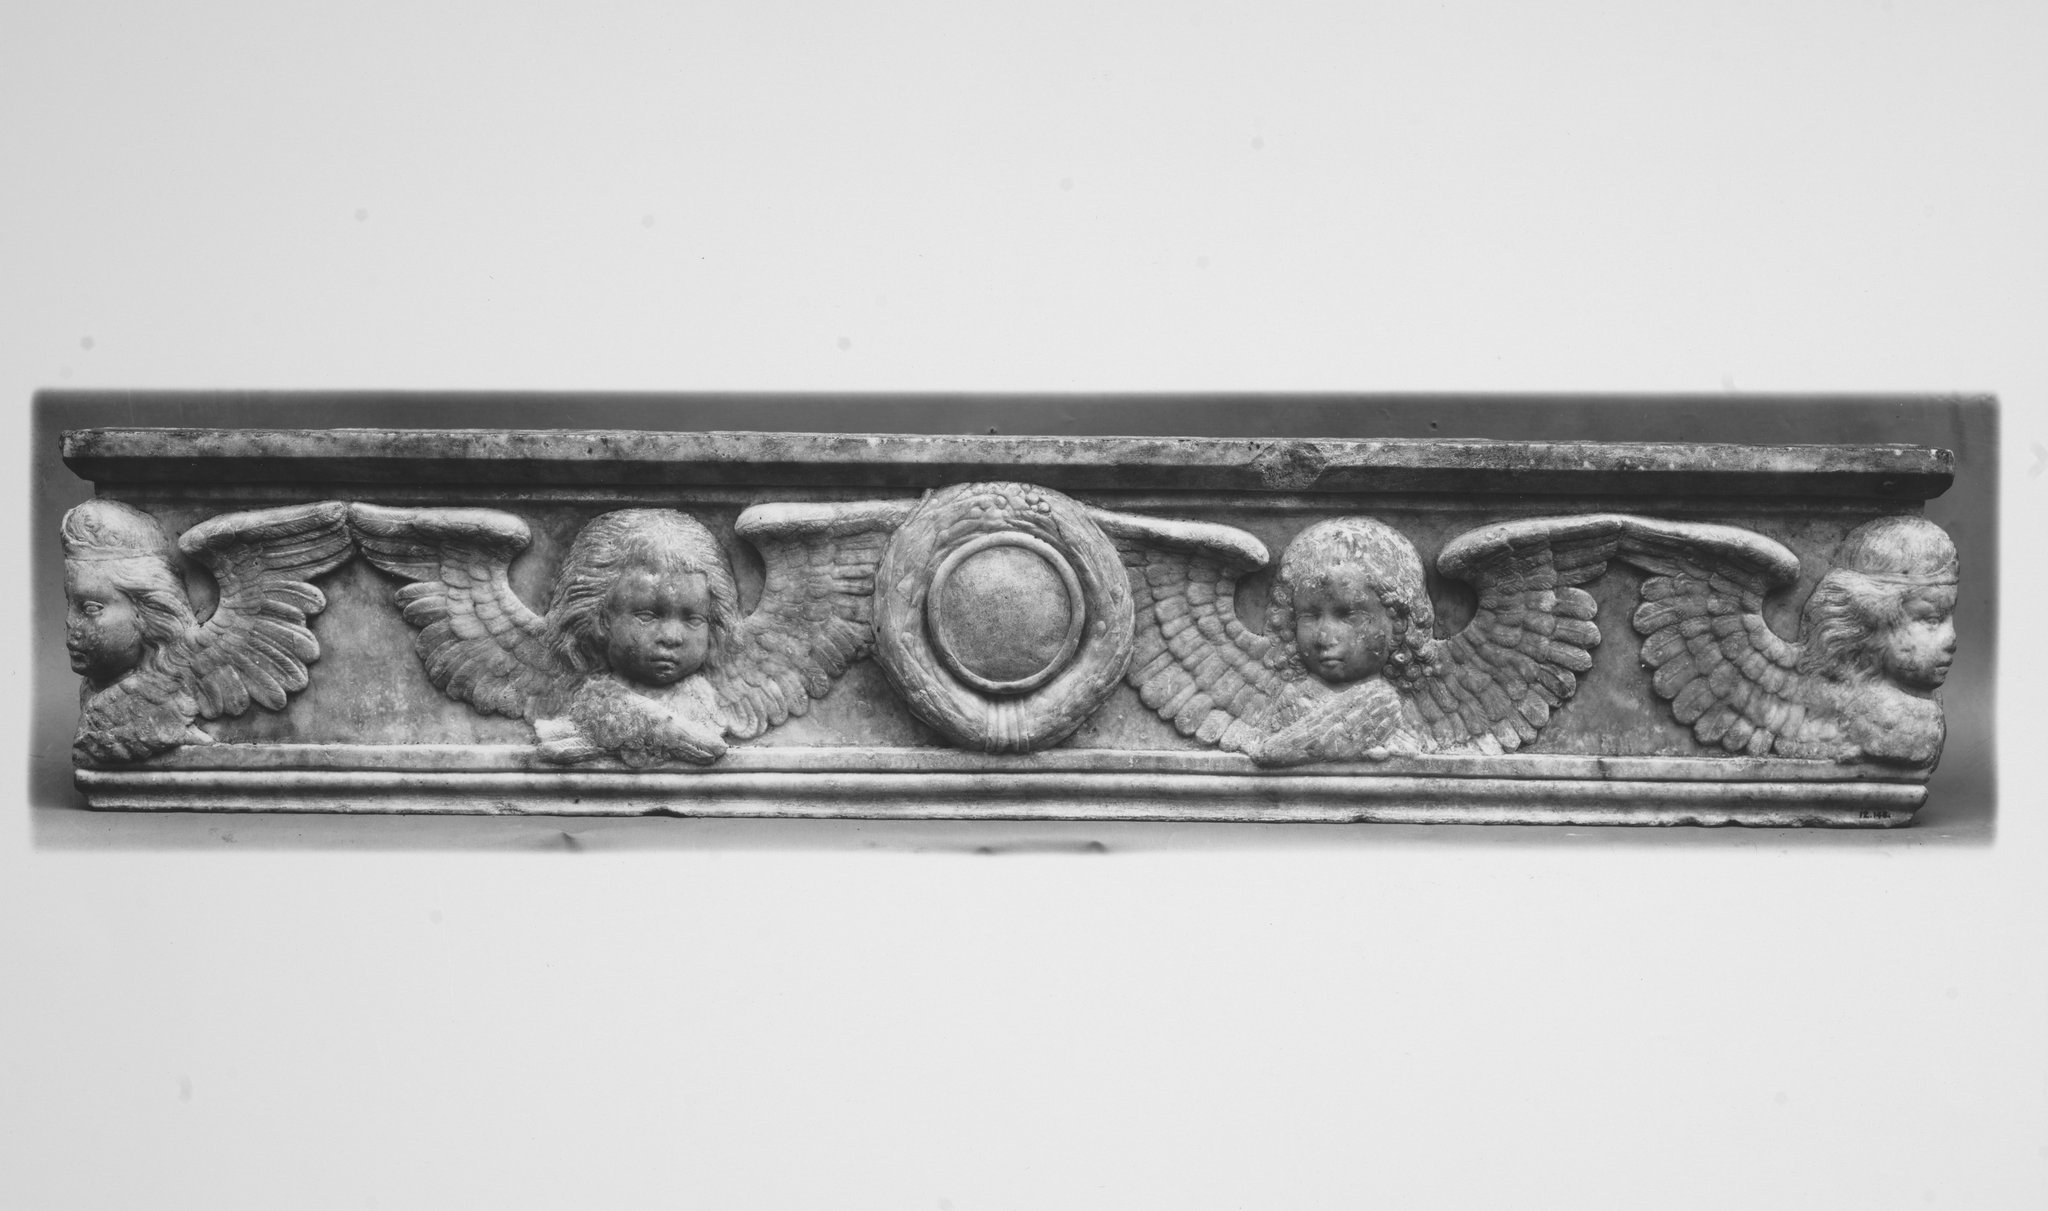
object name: mantel frieze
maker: andrea bregno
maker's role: artist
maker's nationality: italian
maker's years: 1418-1503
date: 1451-1500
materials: marble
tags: heads